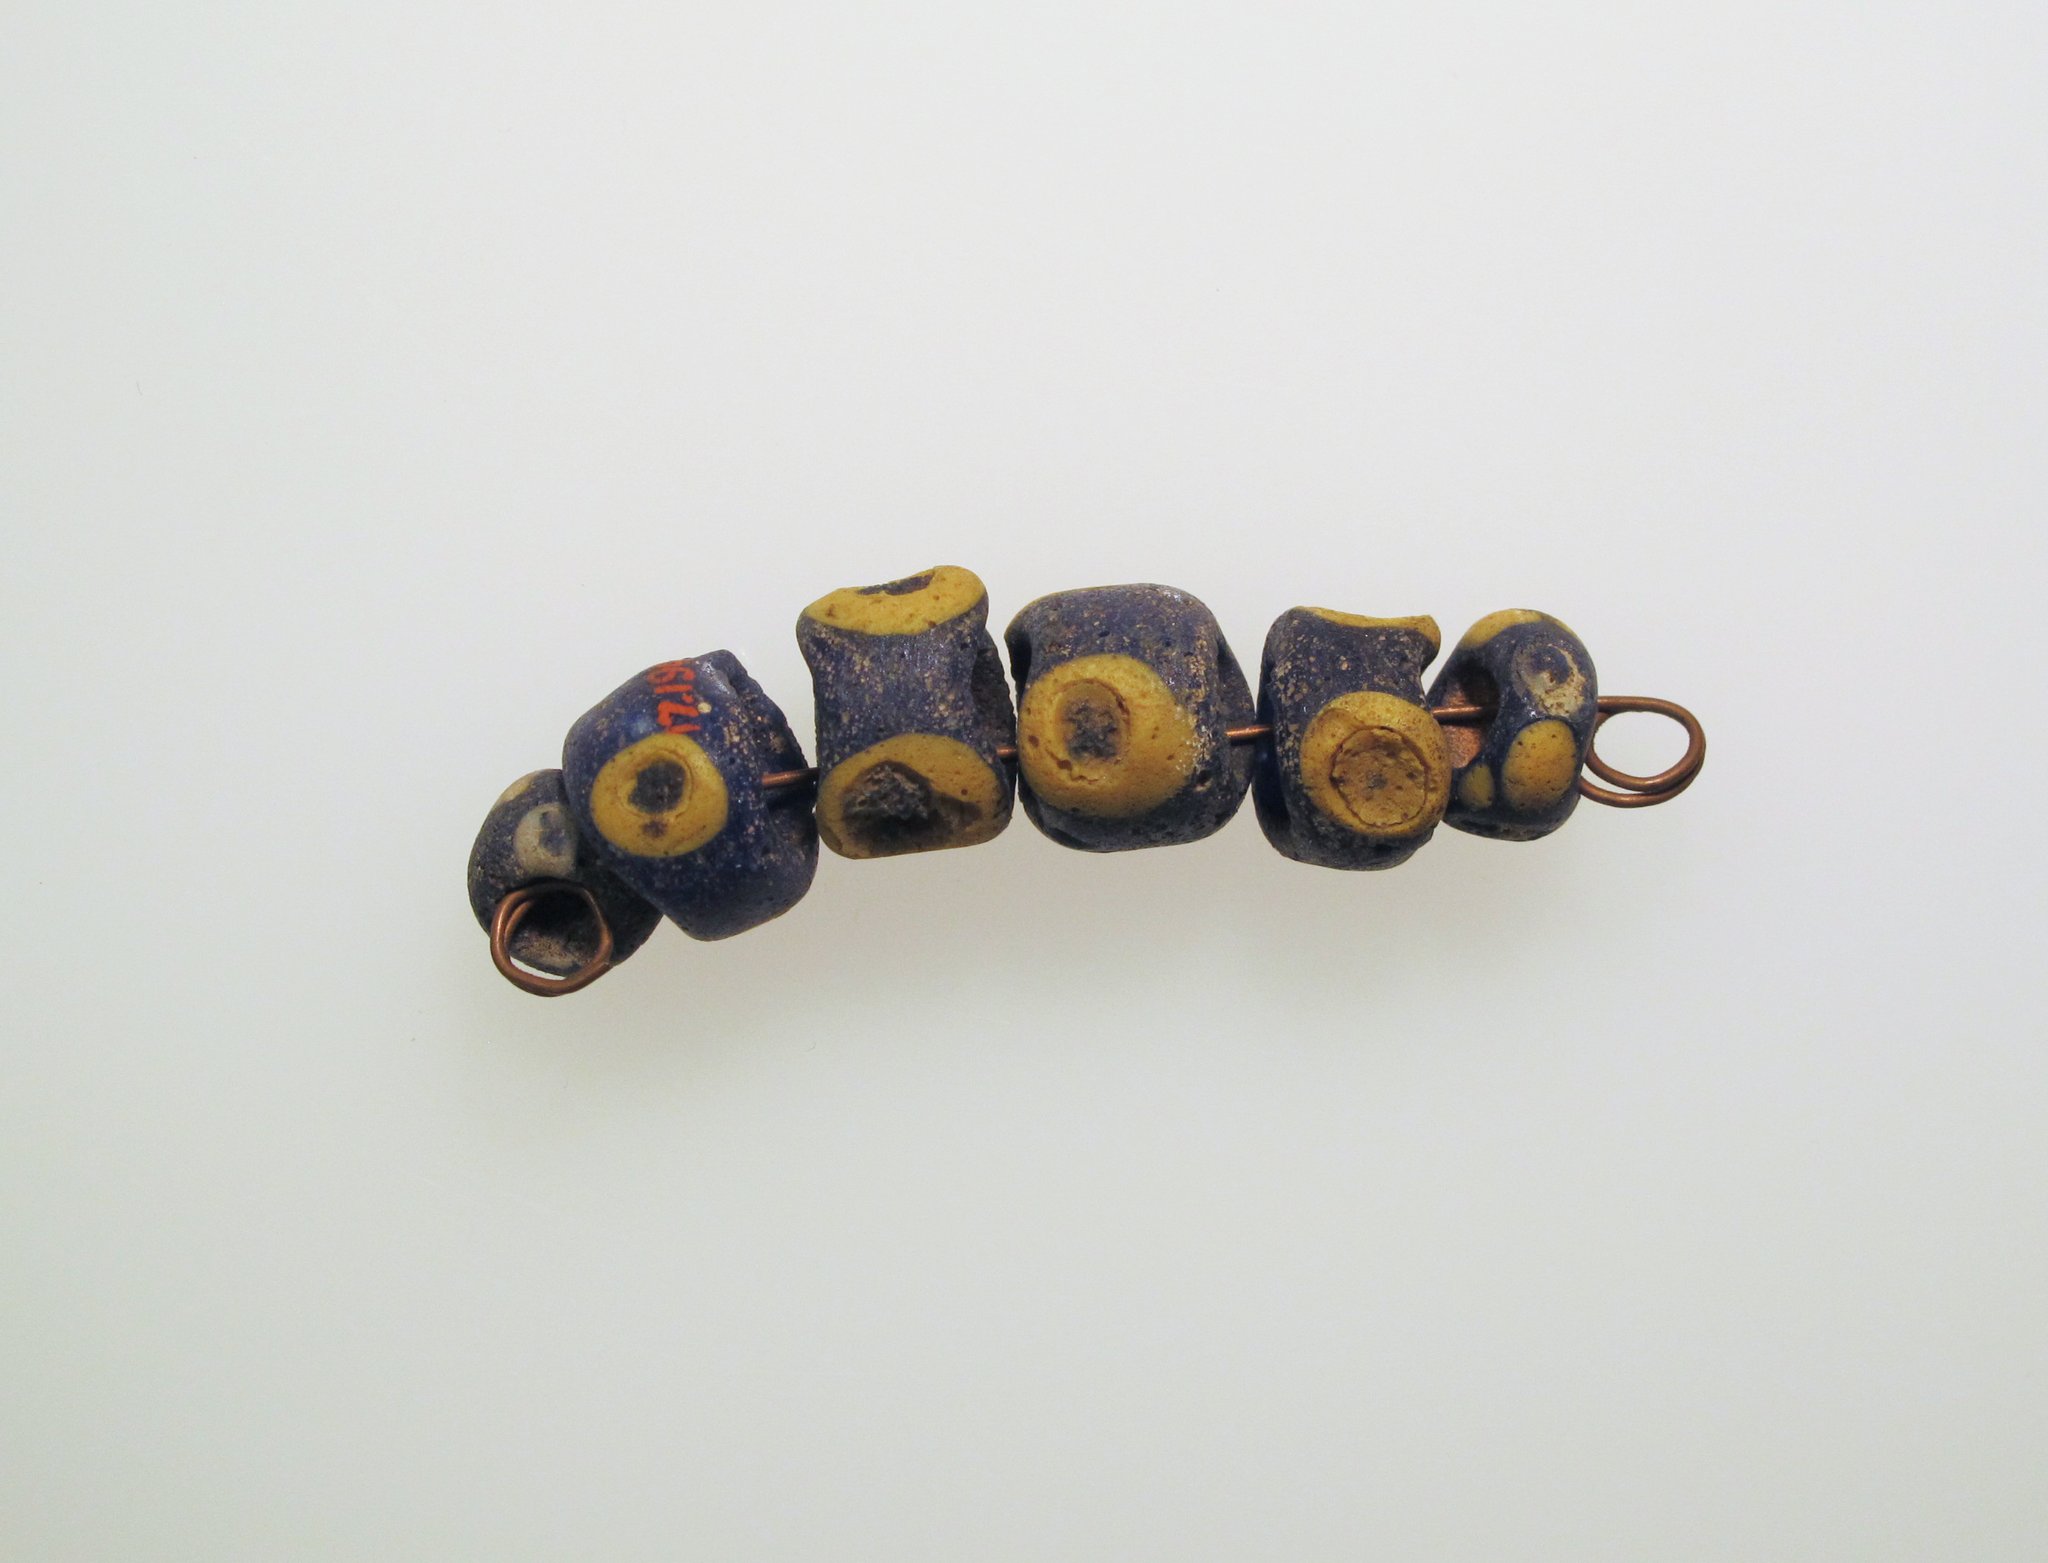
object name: bead, 6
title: Beads, 6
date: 7000 BCE-330 CE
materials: glass